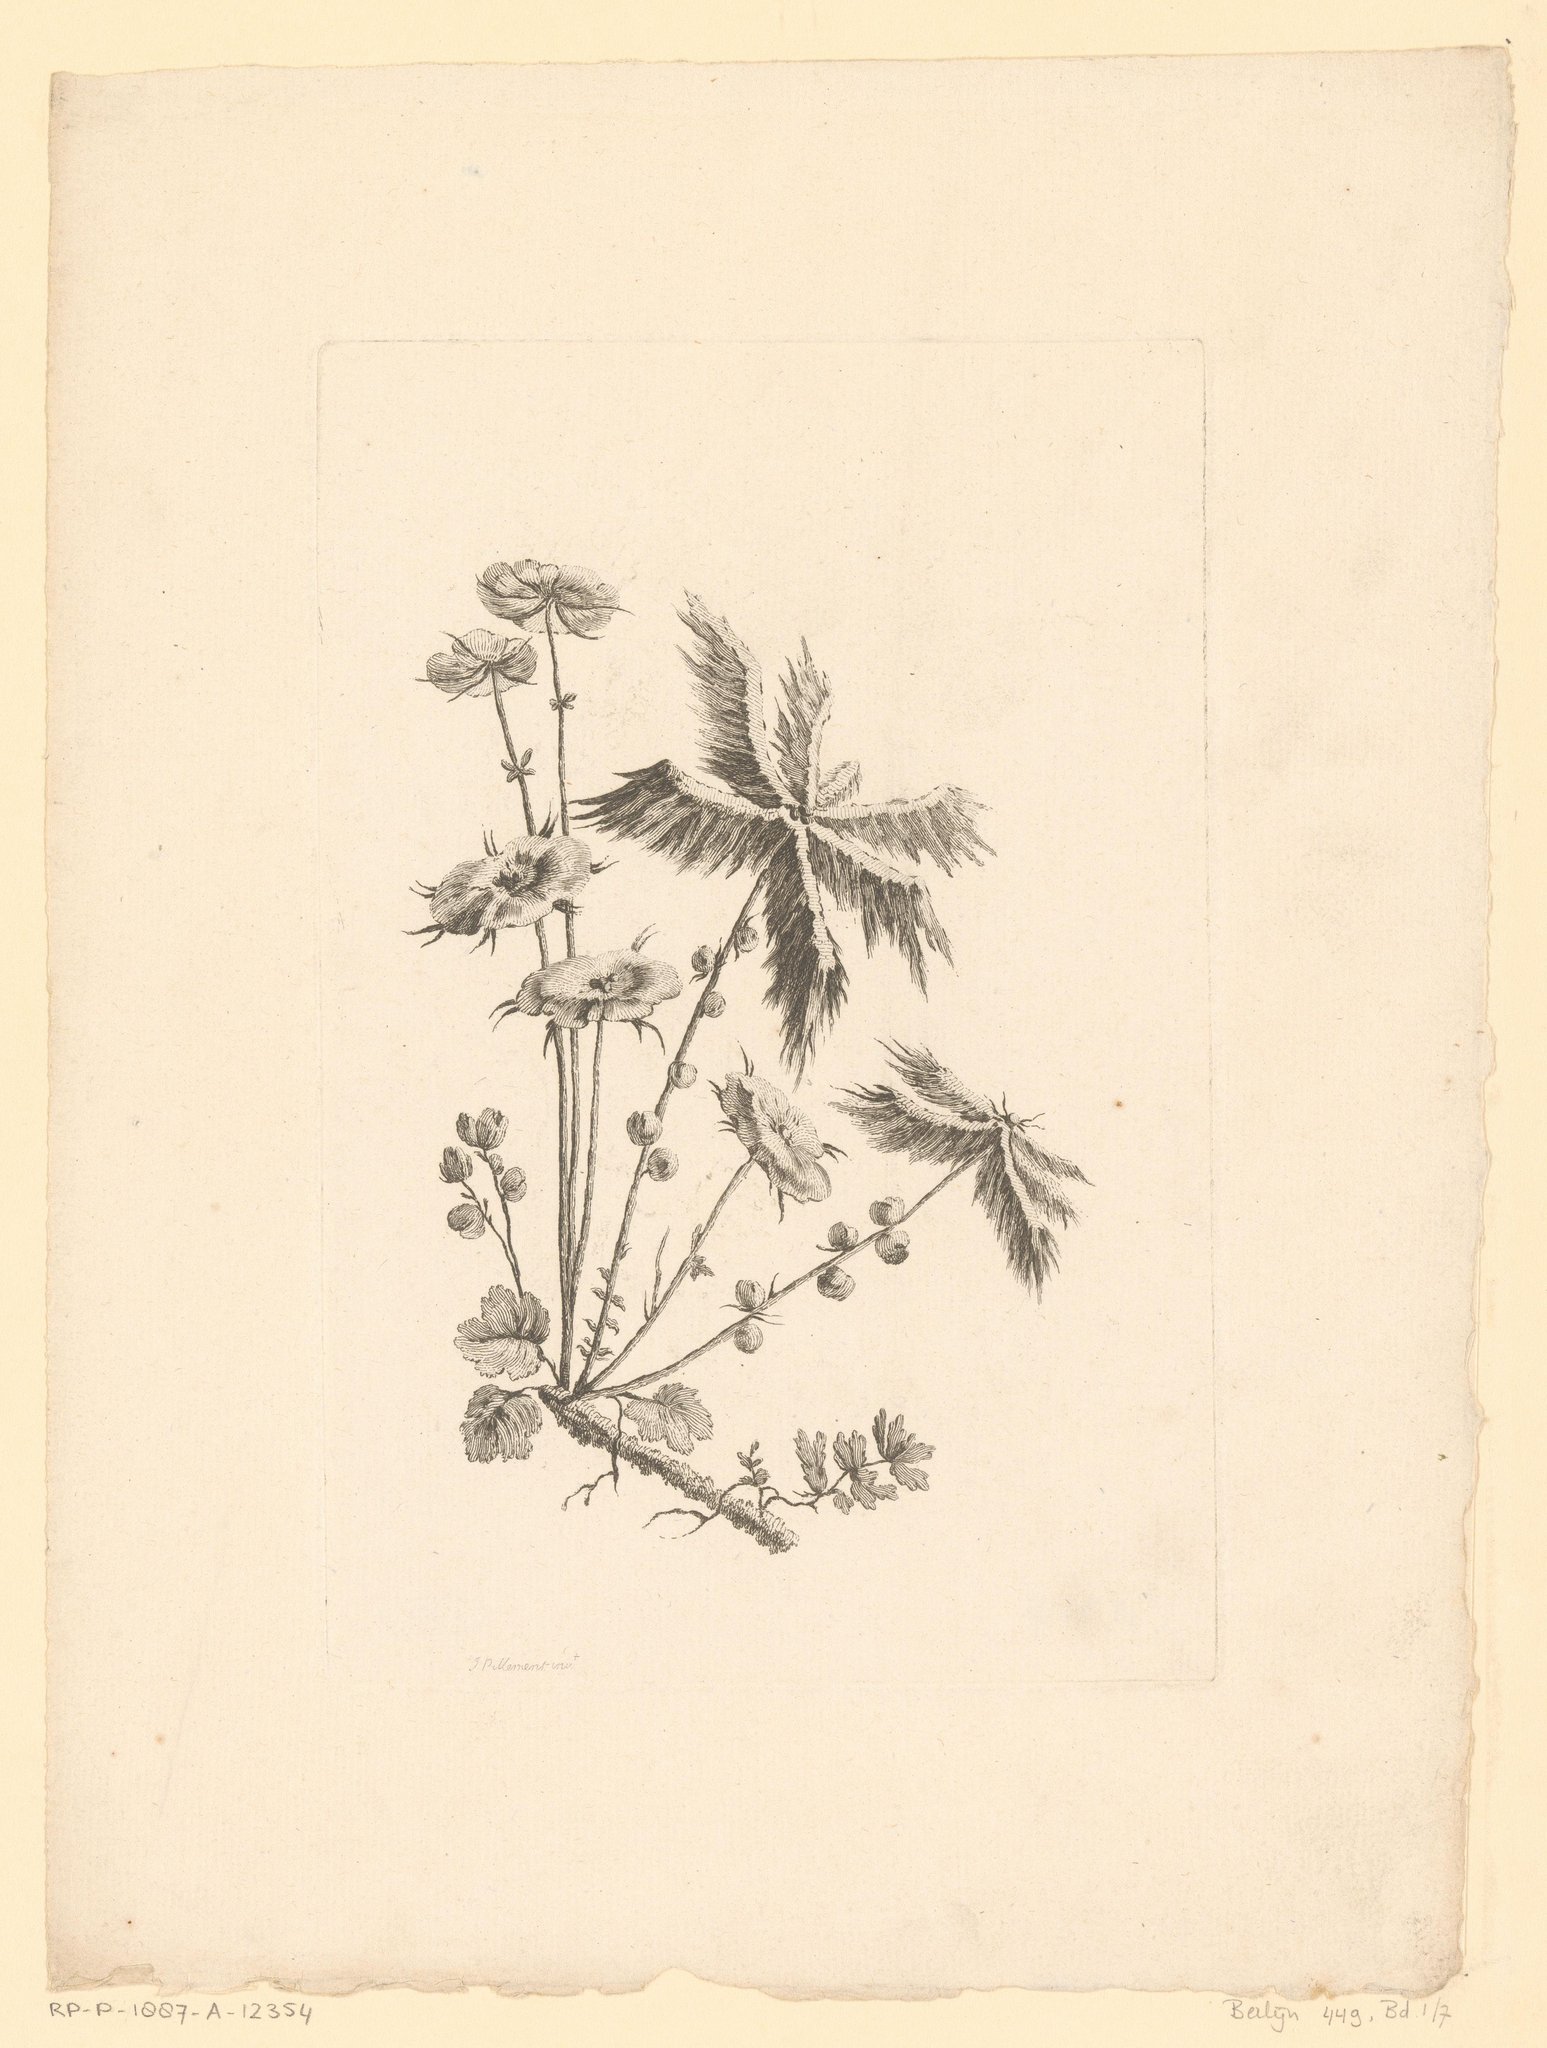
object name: print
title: Bloemen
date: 1760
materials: paper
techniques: etching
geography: paris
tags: flowers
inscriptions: collector's mark: Lugt 2228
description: Platte bloemen en bloemen met dunne langwerpige bladeren.